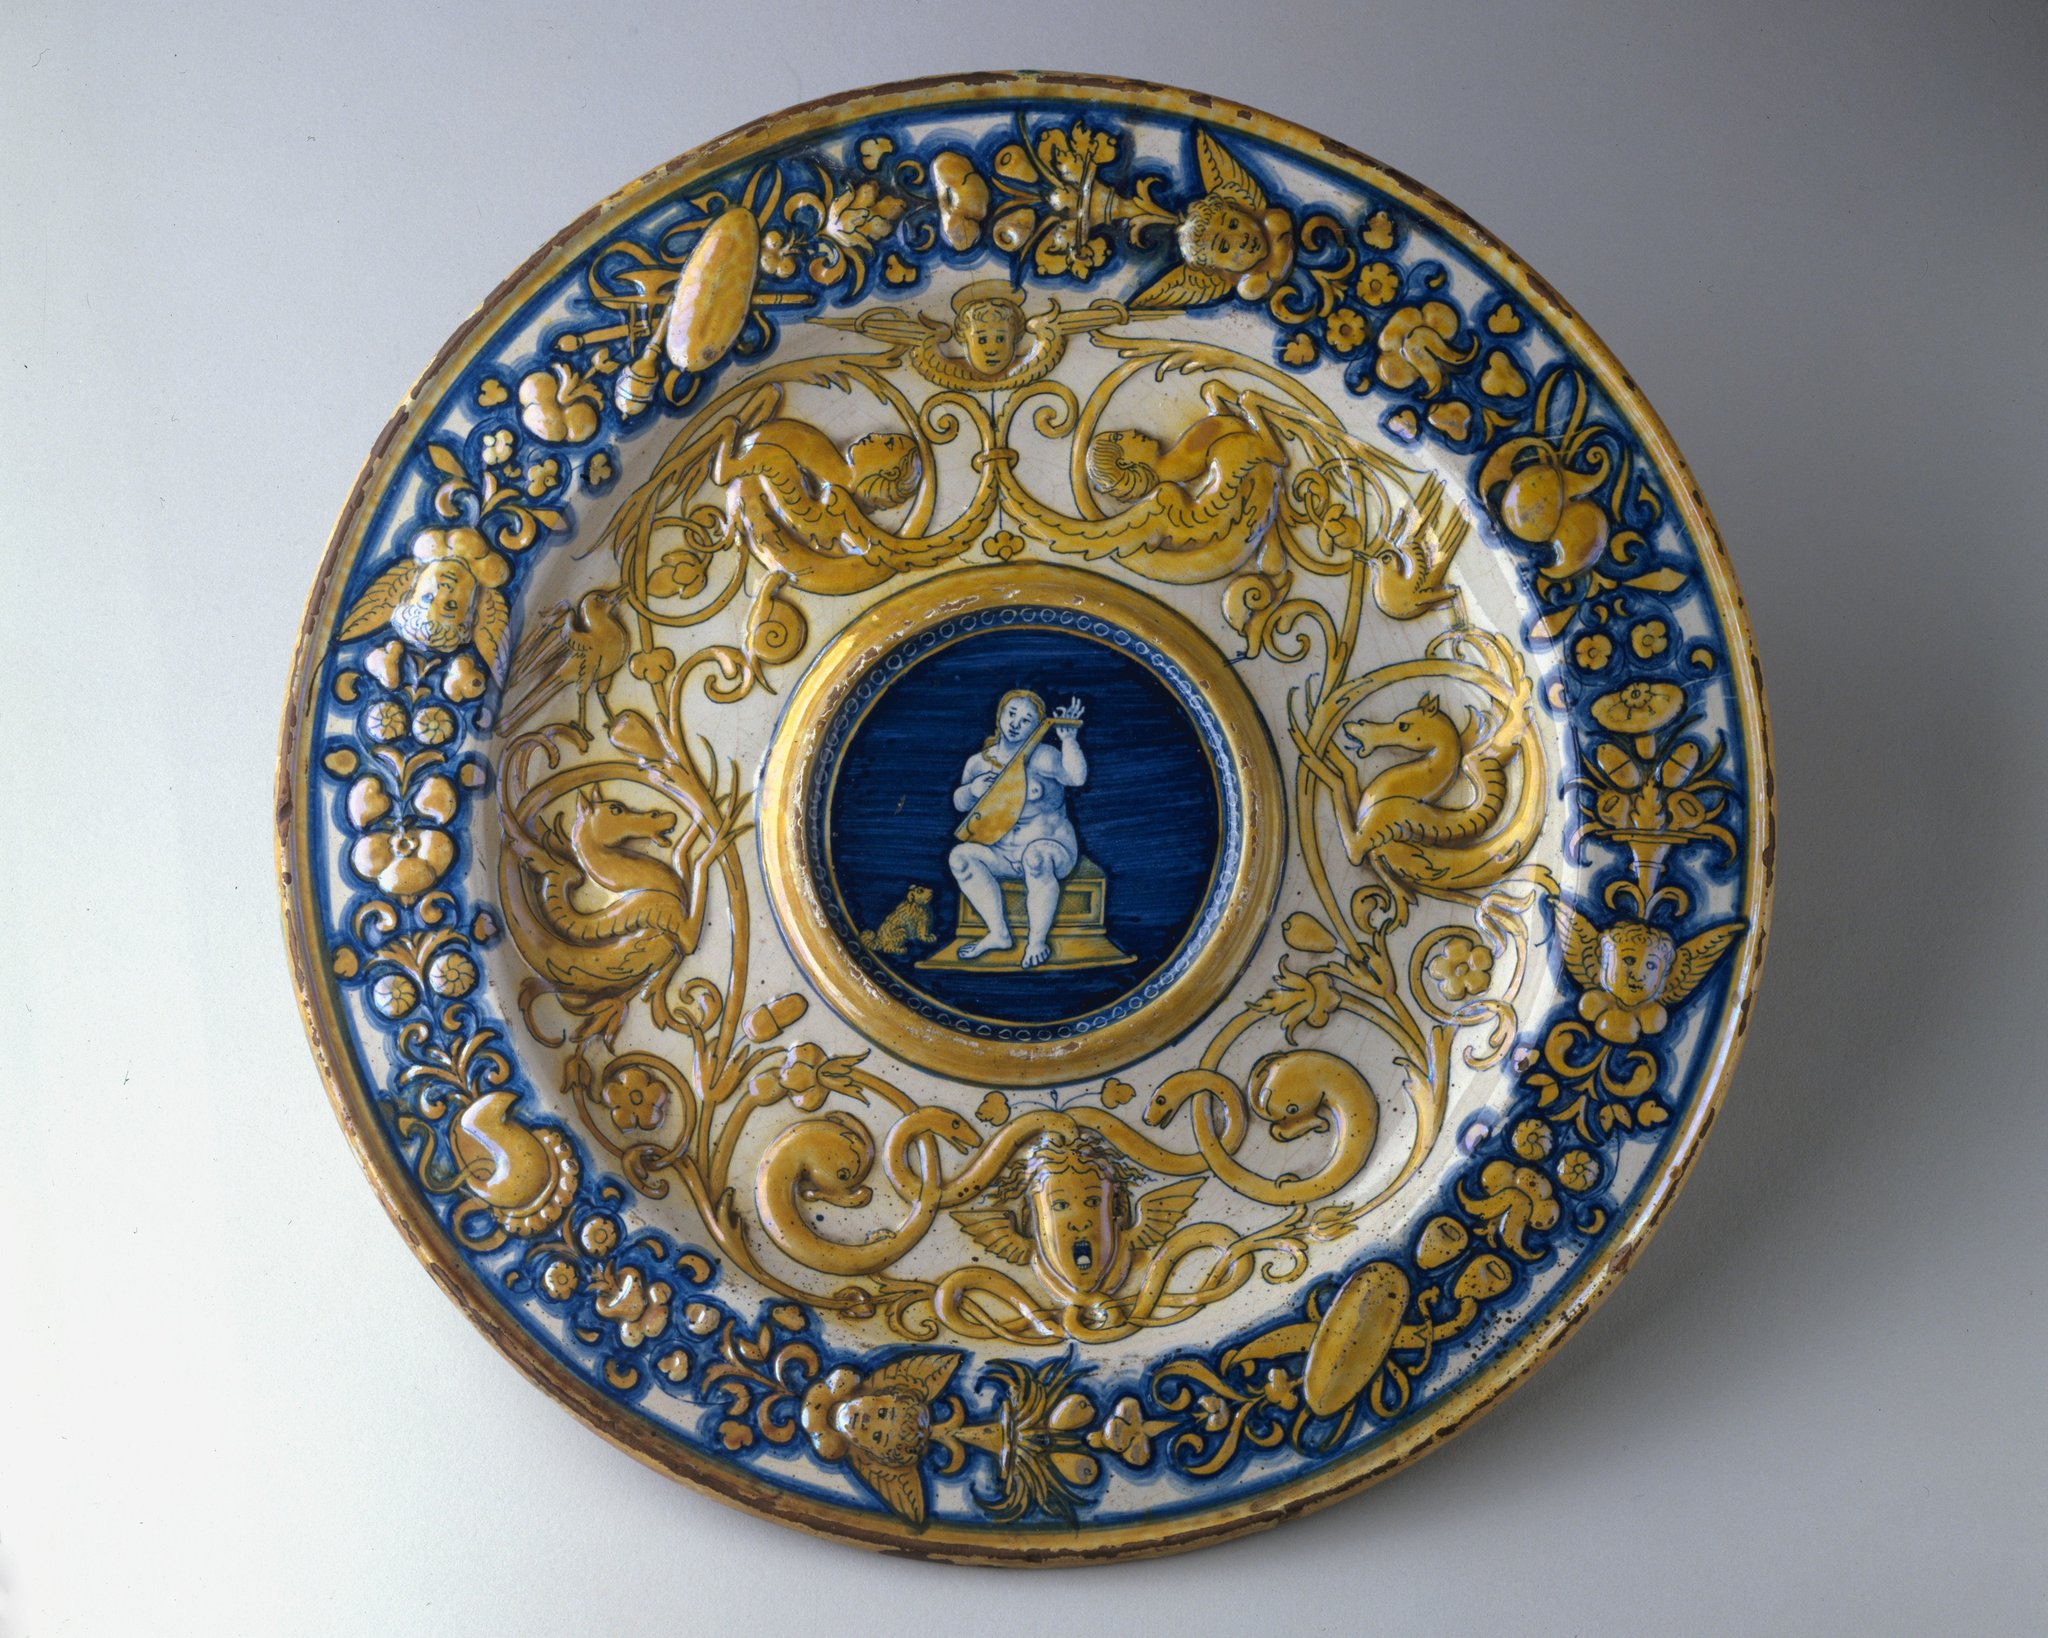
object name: ewer dish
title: Dish for a ewer (bacile da versatore)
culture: italian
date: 1520-1530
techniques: maiolica, glazing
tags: women,lutes,dogs